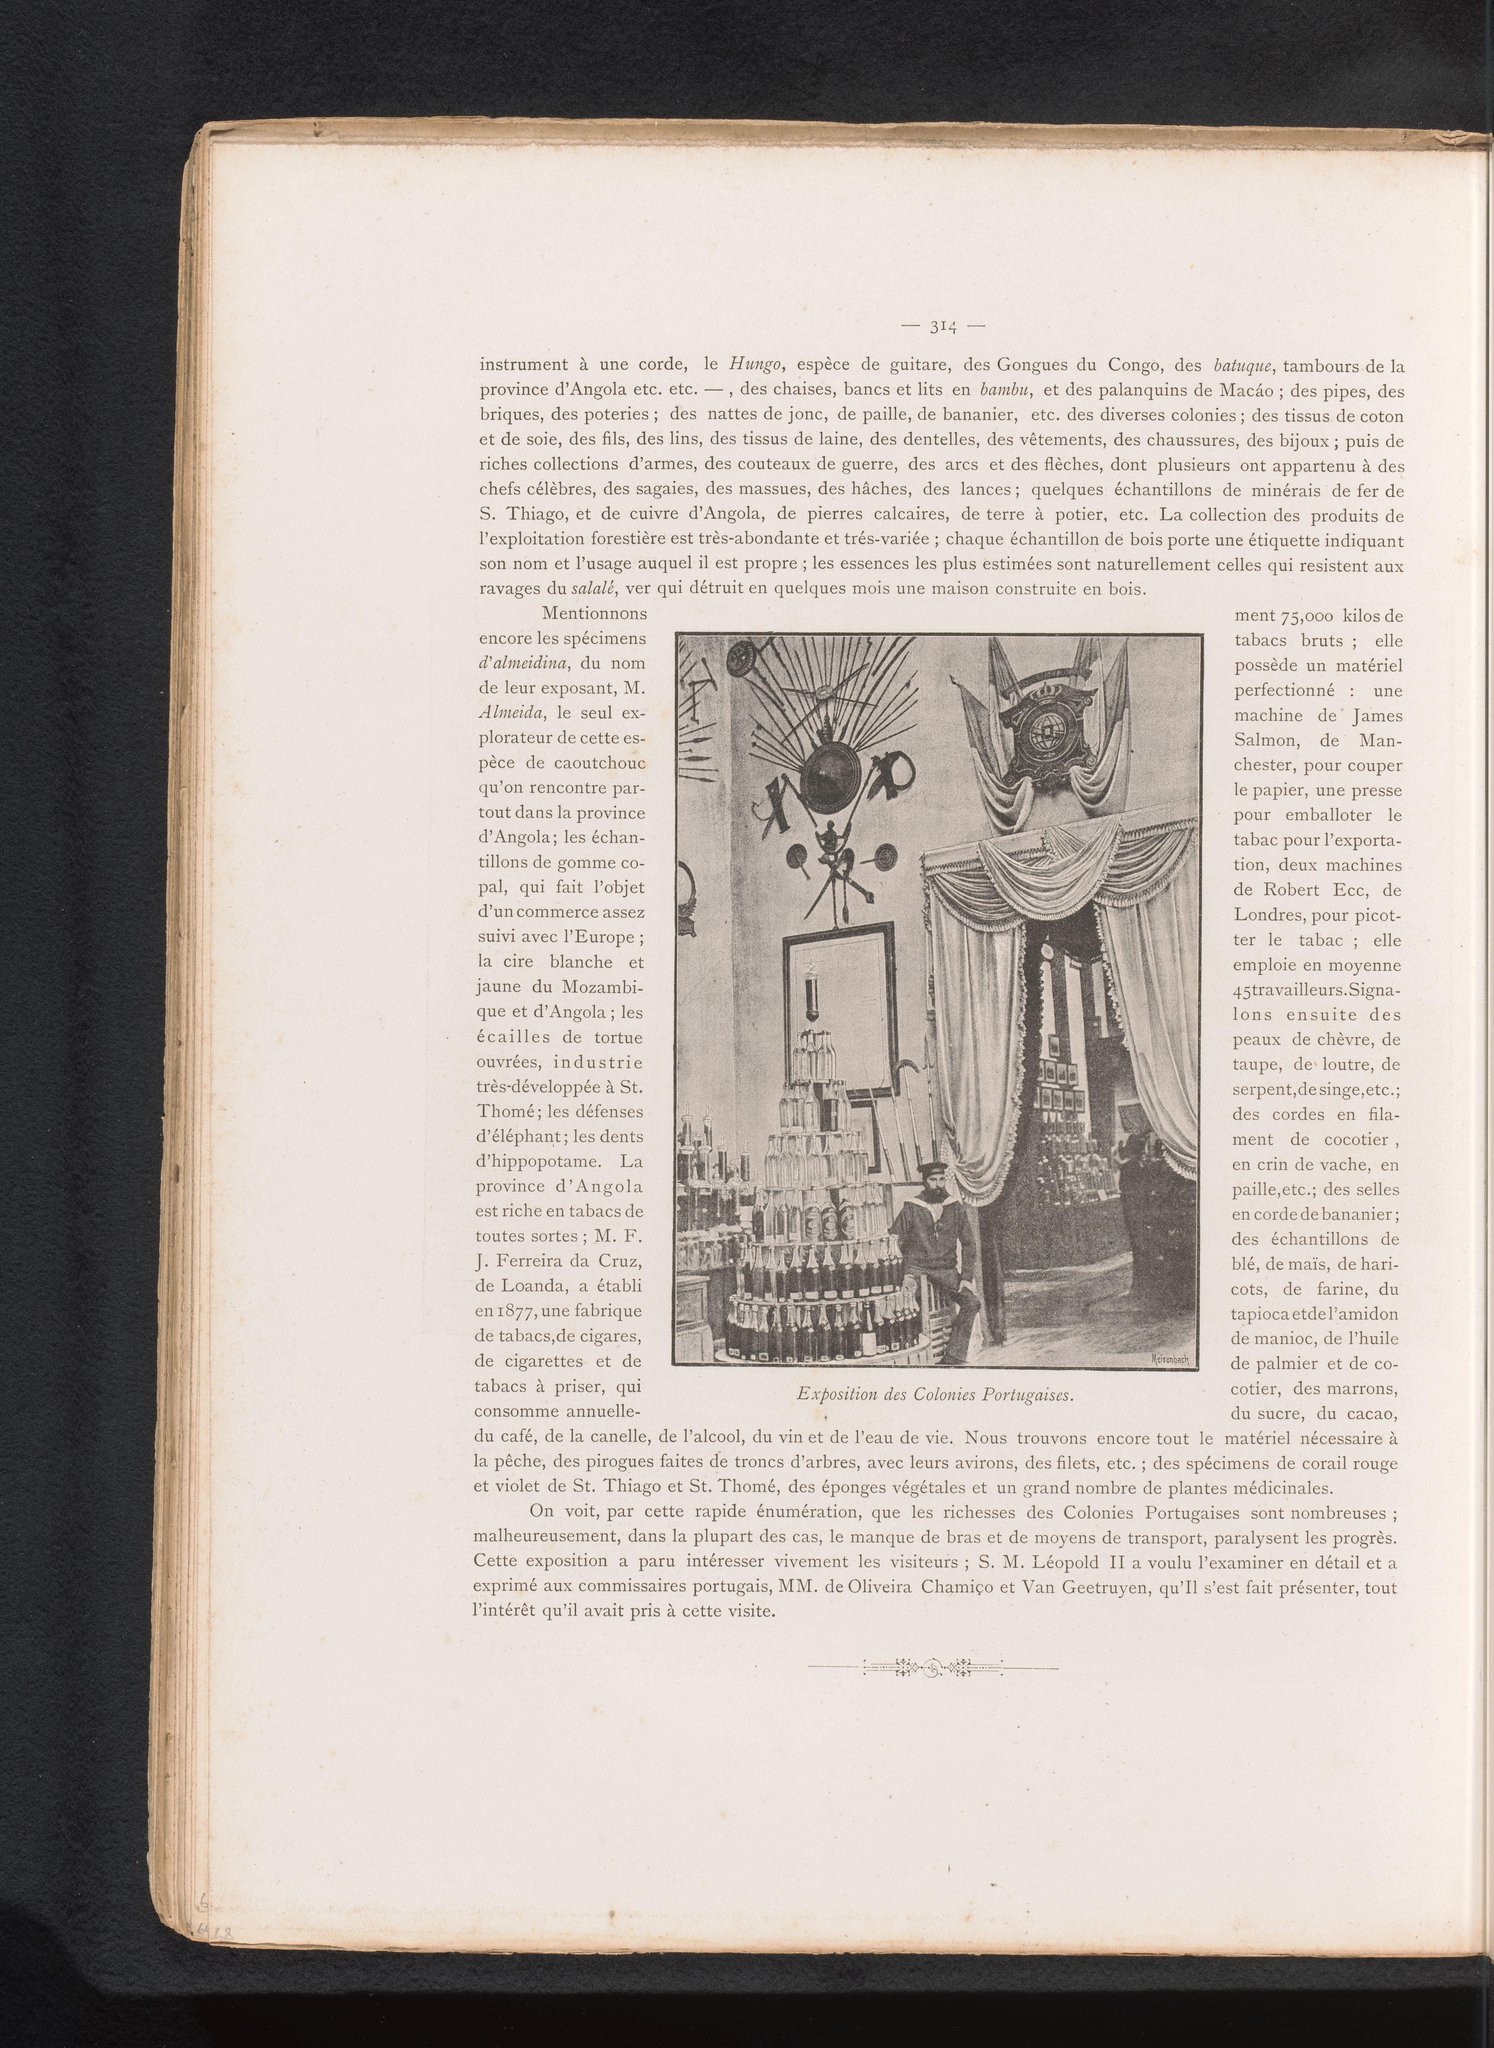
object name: page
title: Gezicht op het interieur van het paviljoen van de Portugese koloniën op de Wereldtentoonstelling van 1885 in Antwerpen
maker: Anonymous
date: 1880-1885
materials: paper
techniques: autotype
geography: antwerp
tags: world fair, world exhibition, antwerp